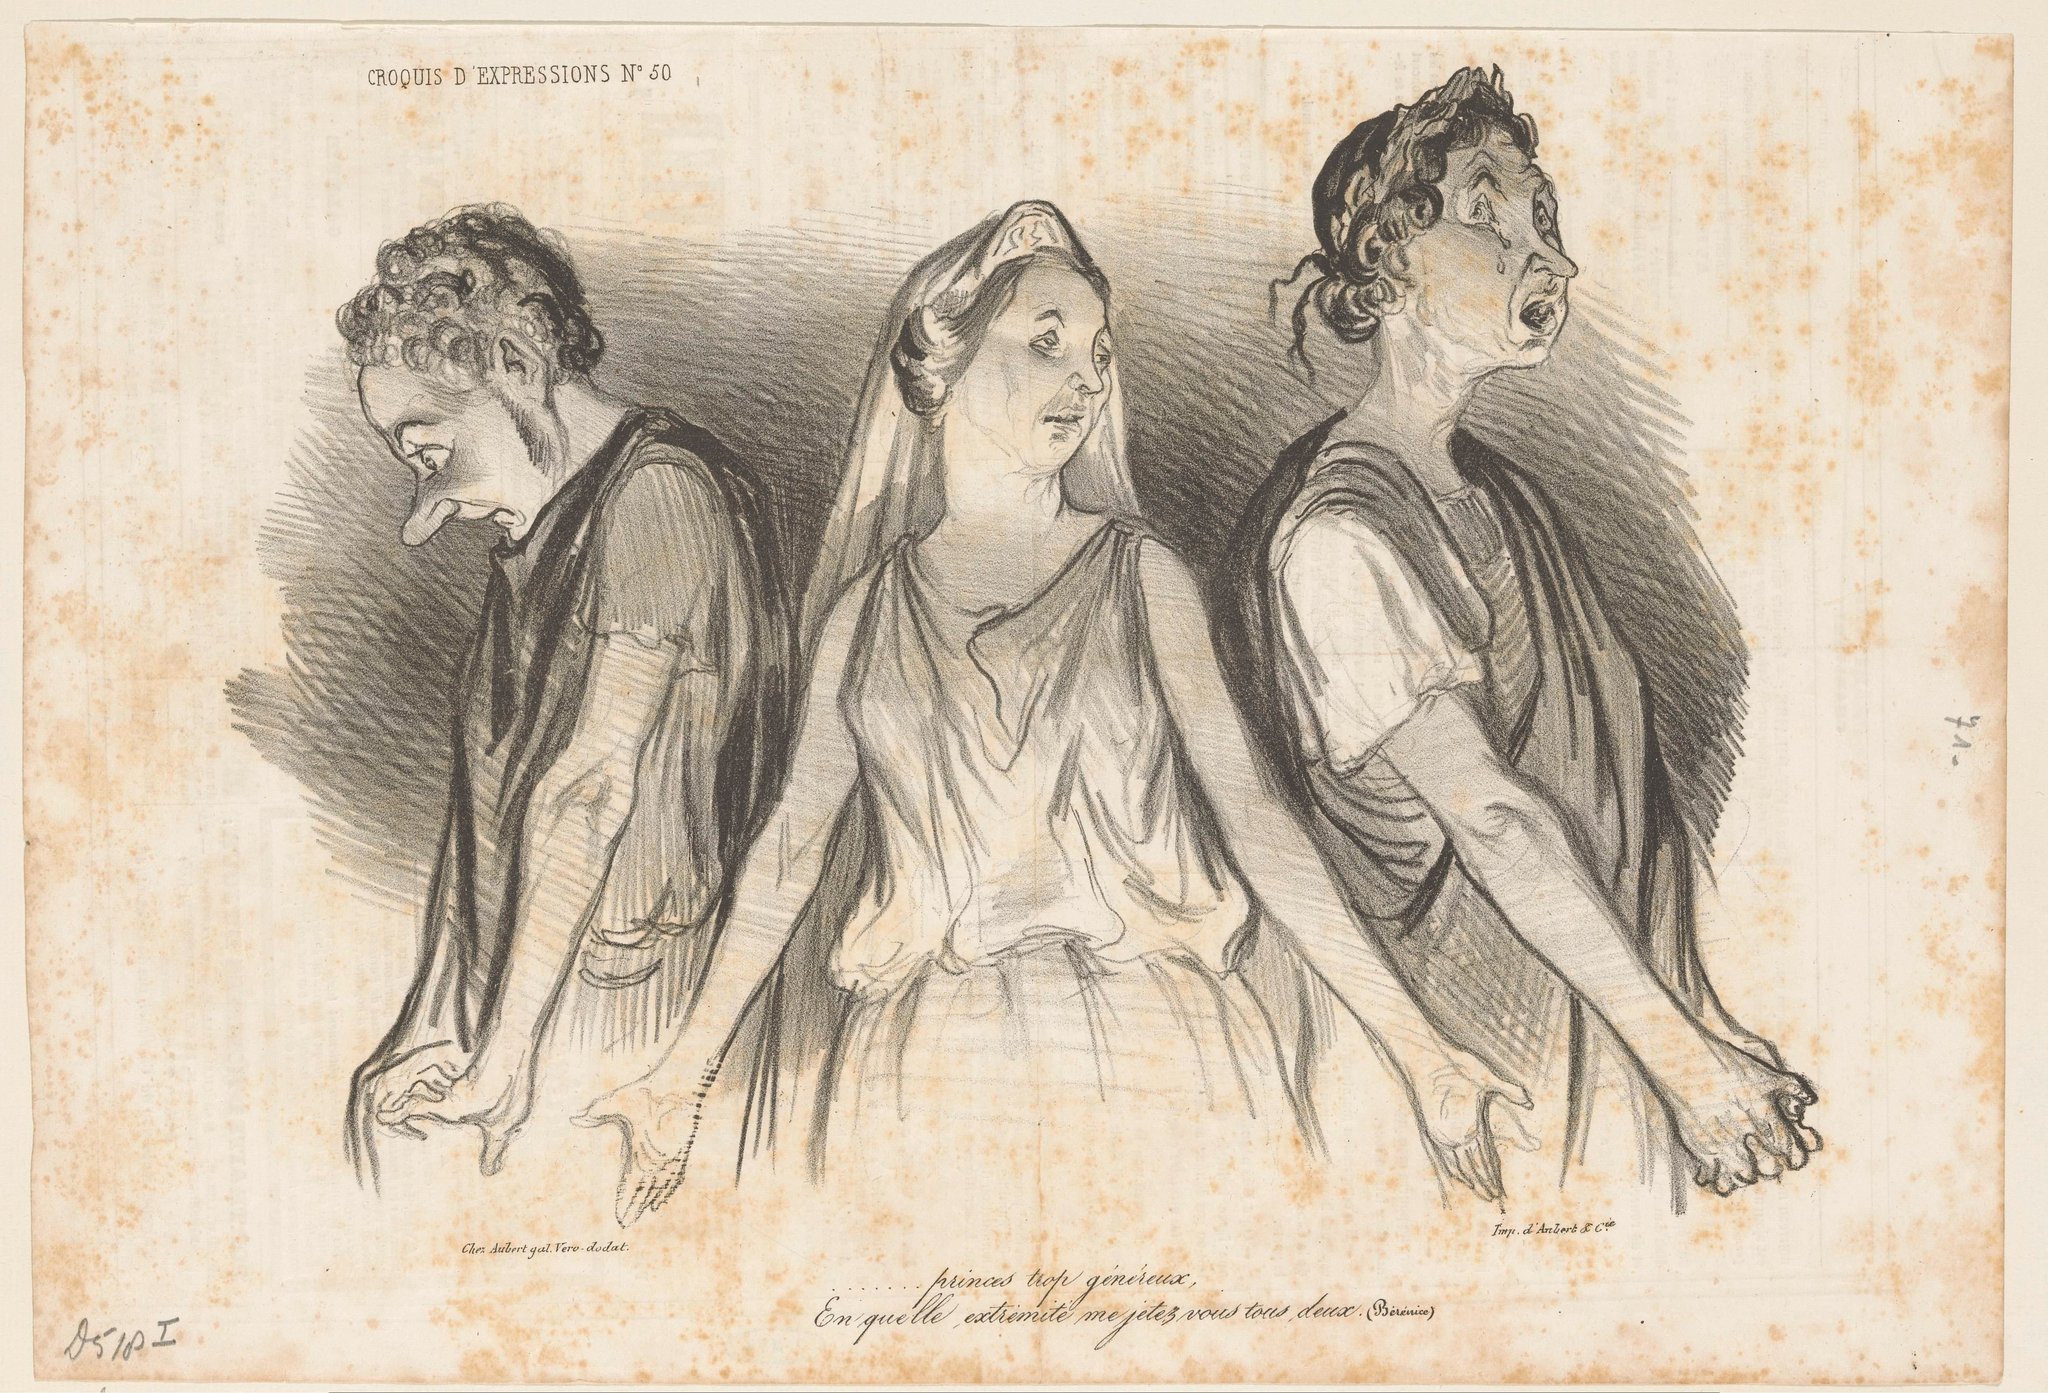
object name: cartoon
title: Princes trop généreux (...)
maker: honoré daumier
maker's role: draughtsman, painter, print maker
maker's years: 1808-1879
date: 1839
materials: paper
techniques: letterpress printing, lithograph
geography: paris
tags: the (difficult) choice ~ courting - cc - women making choice, caricatures (human types)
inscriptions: collector's mark: Lugt 2228a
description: Prent mogelijk uit: Le Charivari, 31 maart 1839.